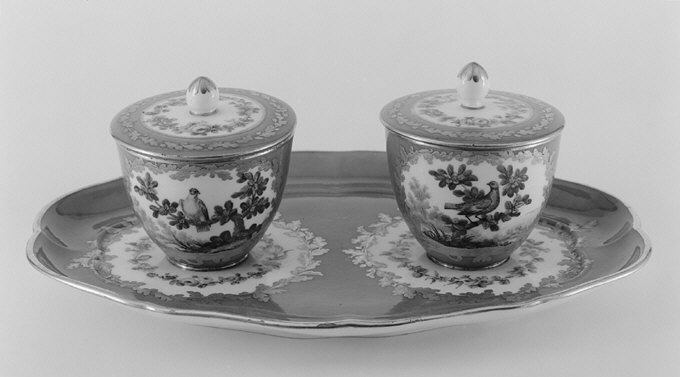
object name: stand with jam pot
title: Stand with jam pots (plateau à deux pots de confiture) (one of a pair) (part of a service)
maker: sèvres manufactory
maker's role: manufactory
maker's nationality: french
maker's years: 1740-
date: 1772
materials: soft paste porcelain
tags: birds,trees